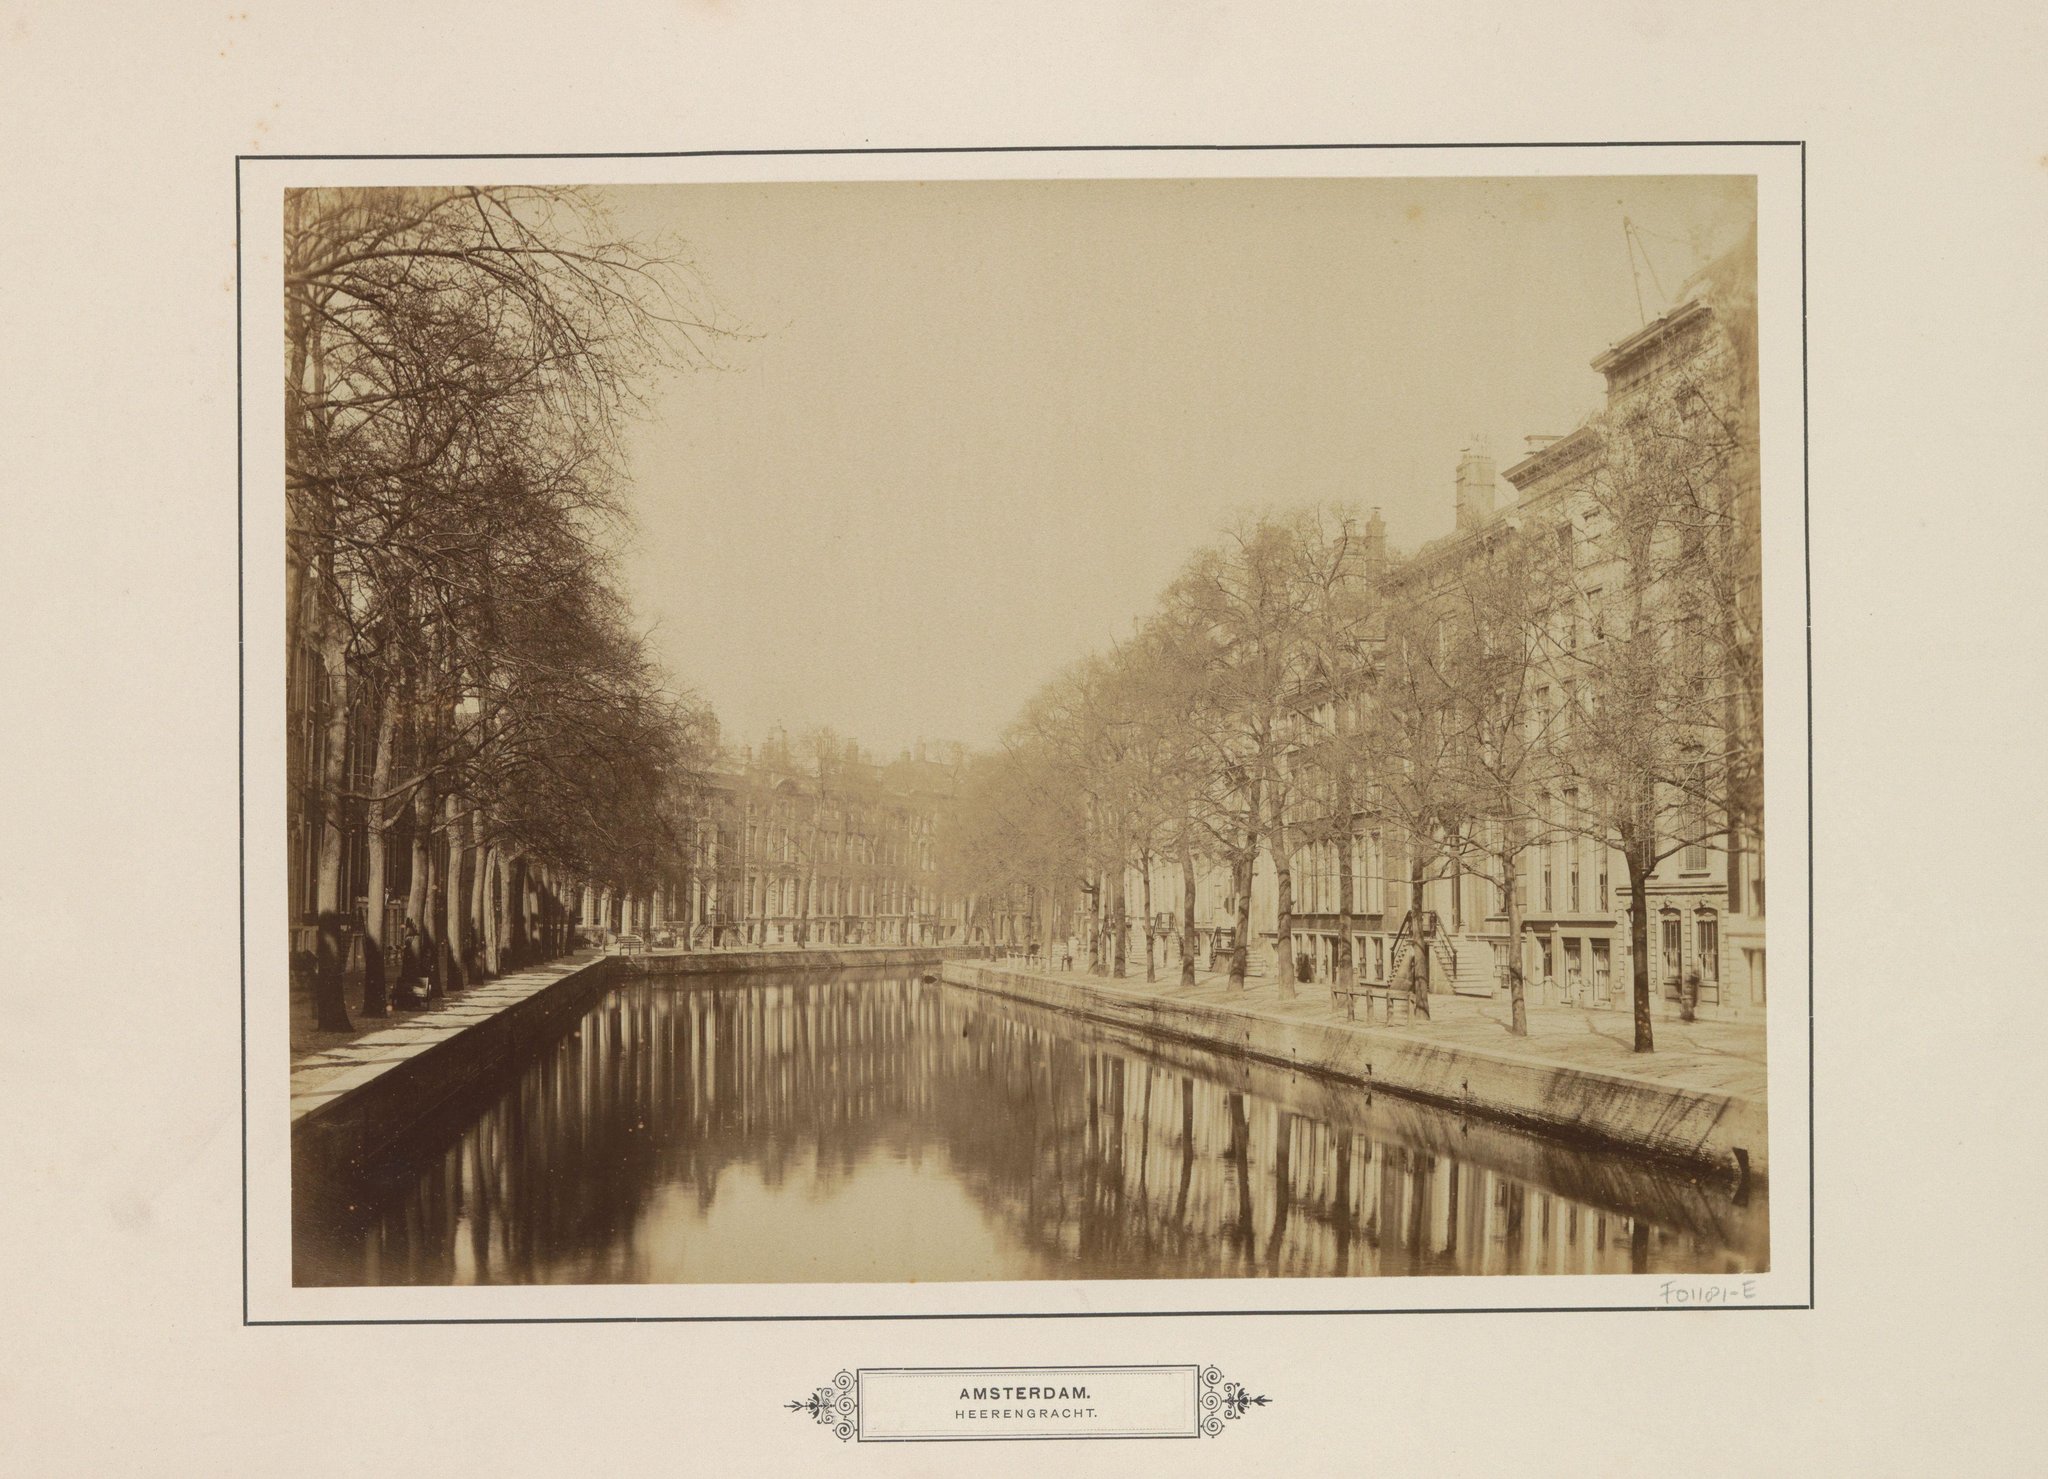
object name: photograph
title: Gezicht op de Gouden Bocht in de Herengracht vanuit het oosten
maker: Anonymous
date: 1880-1895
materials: photographic support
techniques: albumen print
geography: amsterdam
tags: canal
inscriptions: inscription: ‘Hendrik Groote Kalverstraat 43, Amsterdam. Photographic stores. Views from Holland. Photographs from ancient and modern dutch Paintings. Fines ans most complete Collection.’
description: Onderdeel van Fotoalbum met opnames van het centrum van Amsterdam en reclameteksten voor winkels en bedrijven.